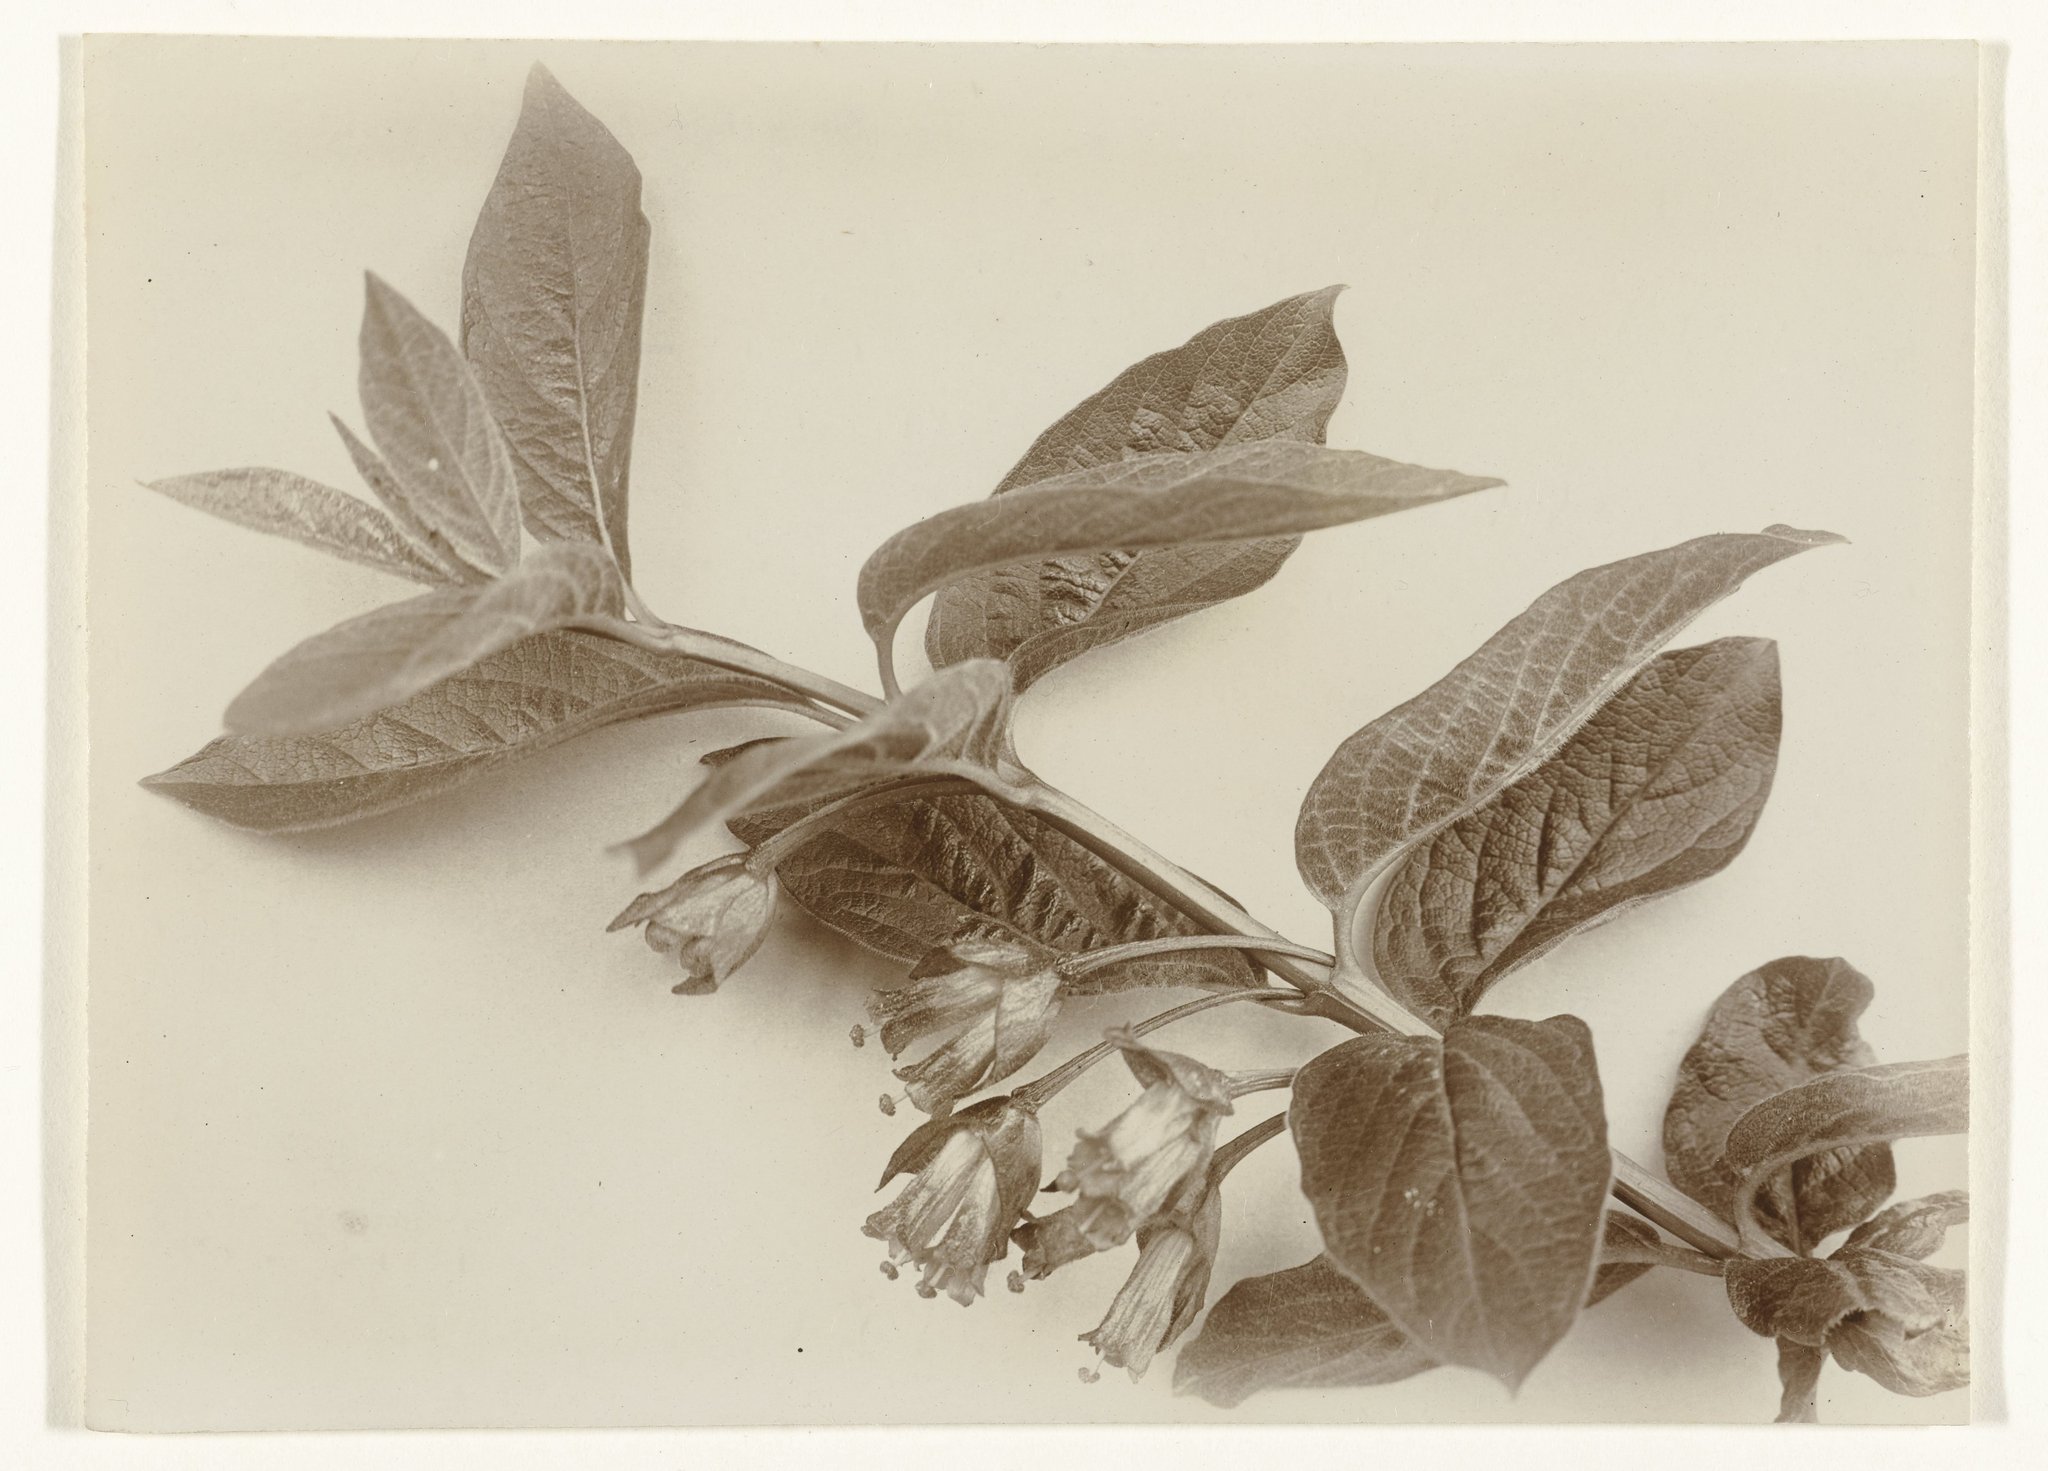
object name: photograph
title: bovenzijde Lonicera Ledebouri bloeiend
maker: richard tepe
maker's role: fotograaf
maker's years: 1864-1952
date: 1900-1930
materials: photographic support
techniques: gelatin silver print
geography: netherlands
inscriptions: signature: ‘foto / R Tepe’, annotation: ‘bovenzijde / Lonicera Ledebouri / bloeiend’